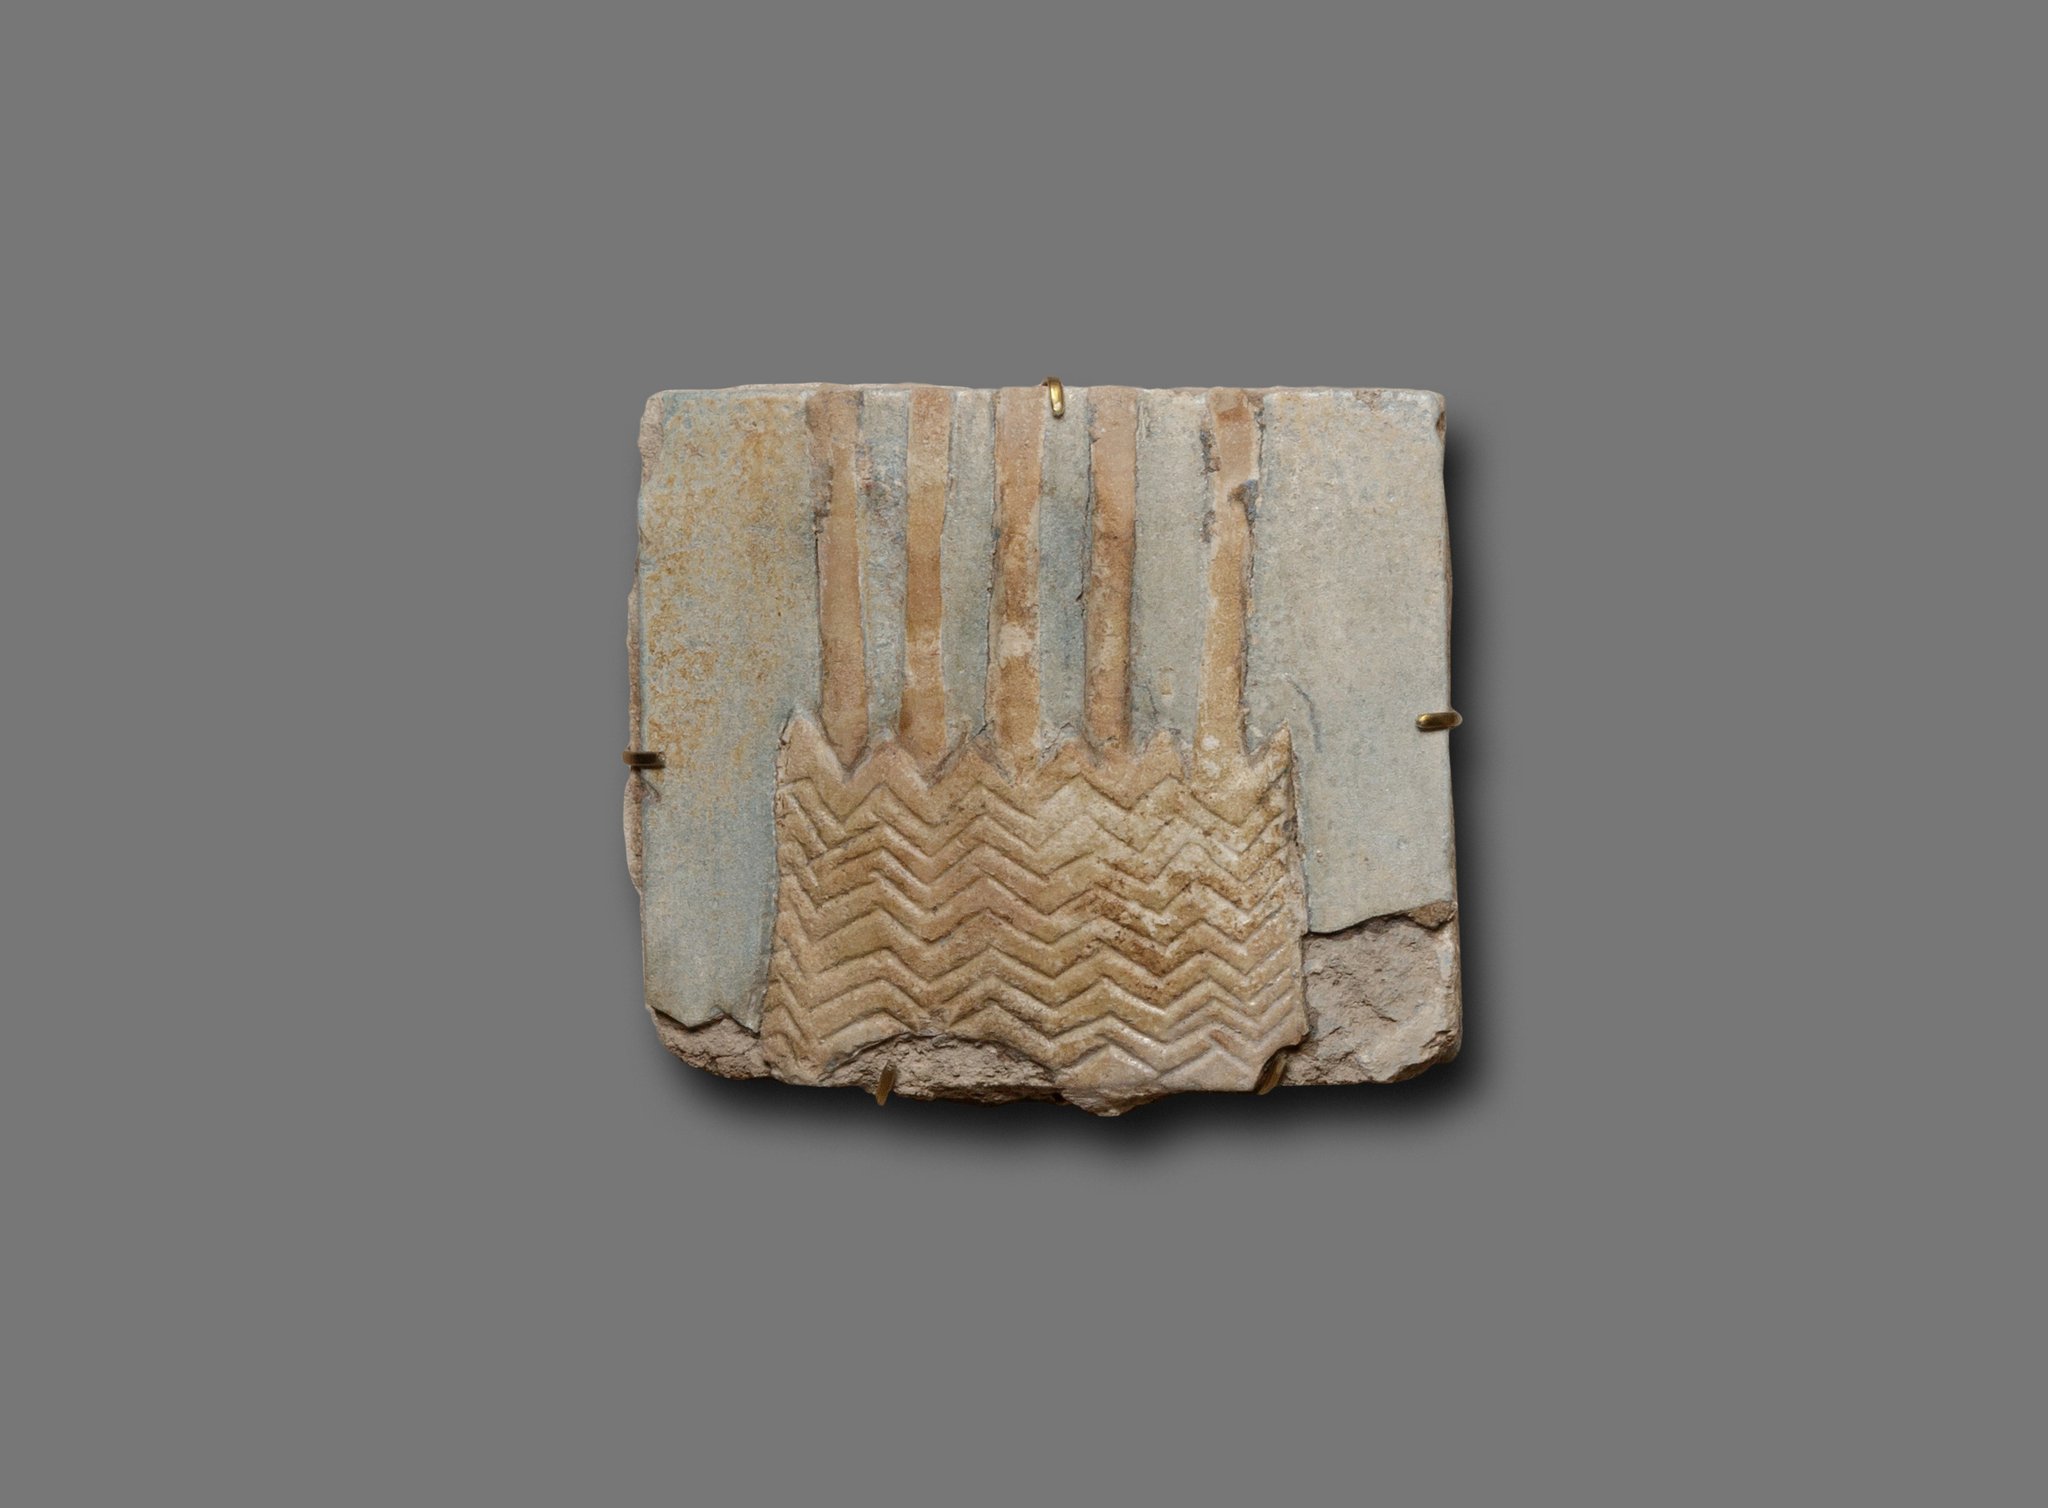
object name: tile, palace of ramesses ii, sedge and papyrus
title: Tile with five stems of a papyrus plant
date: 1279-1213 BCE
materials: faience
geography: egypt